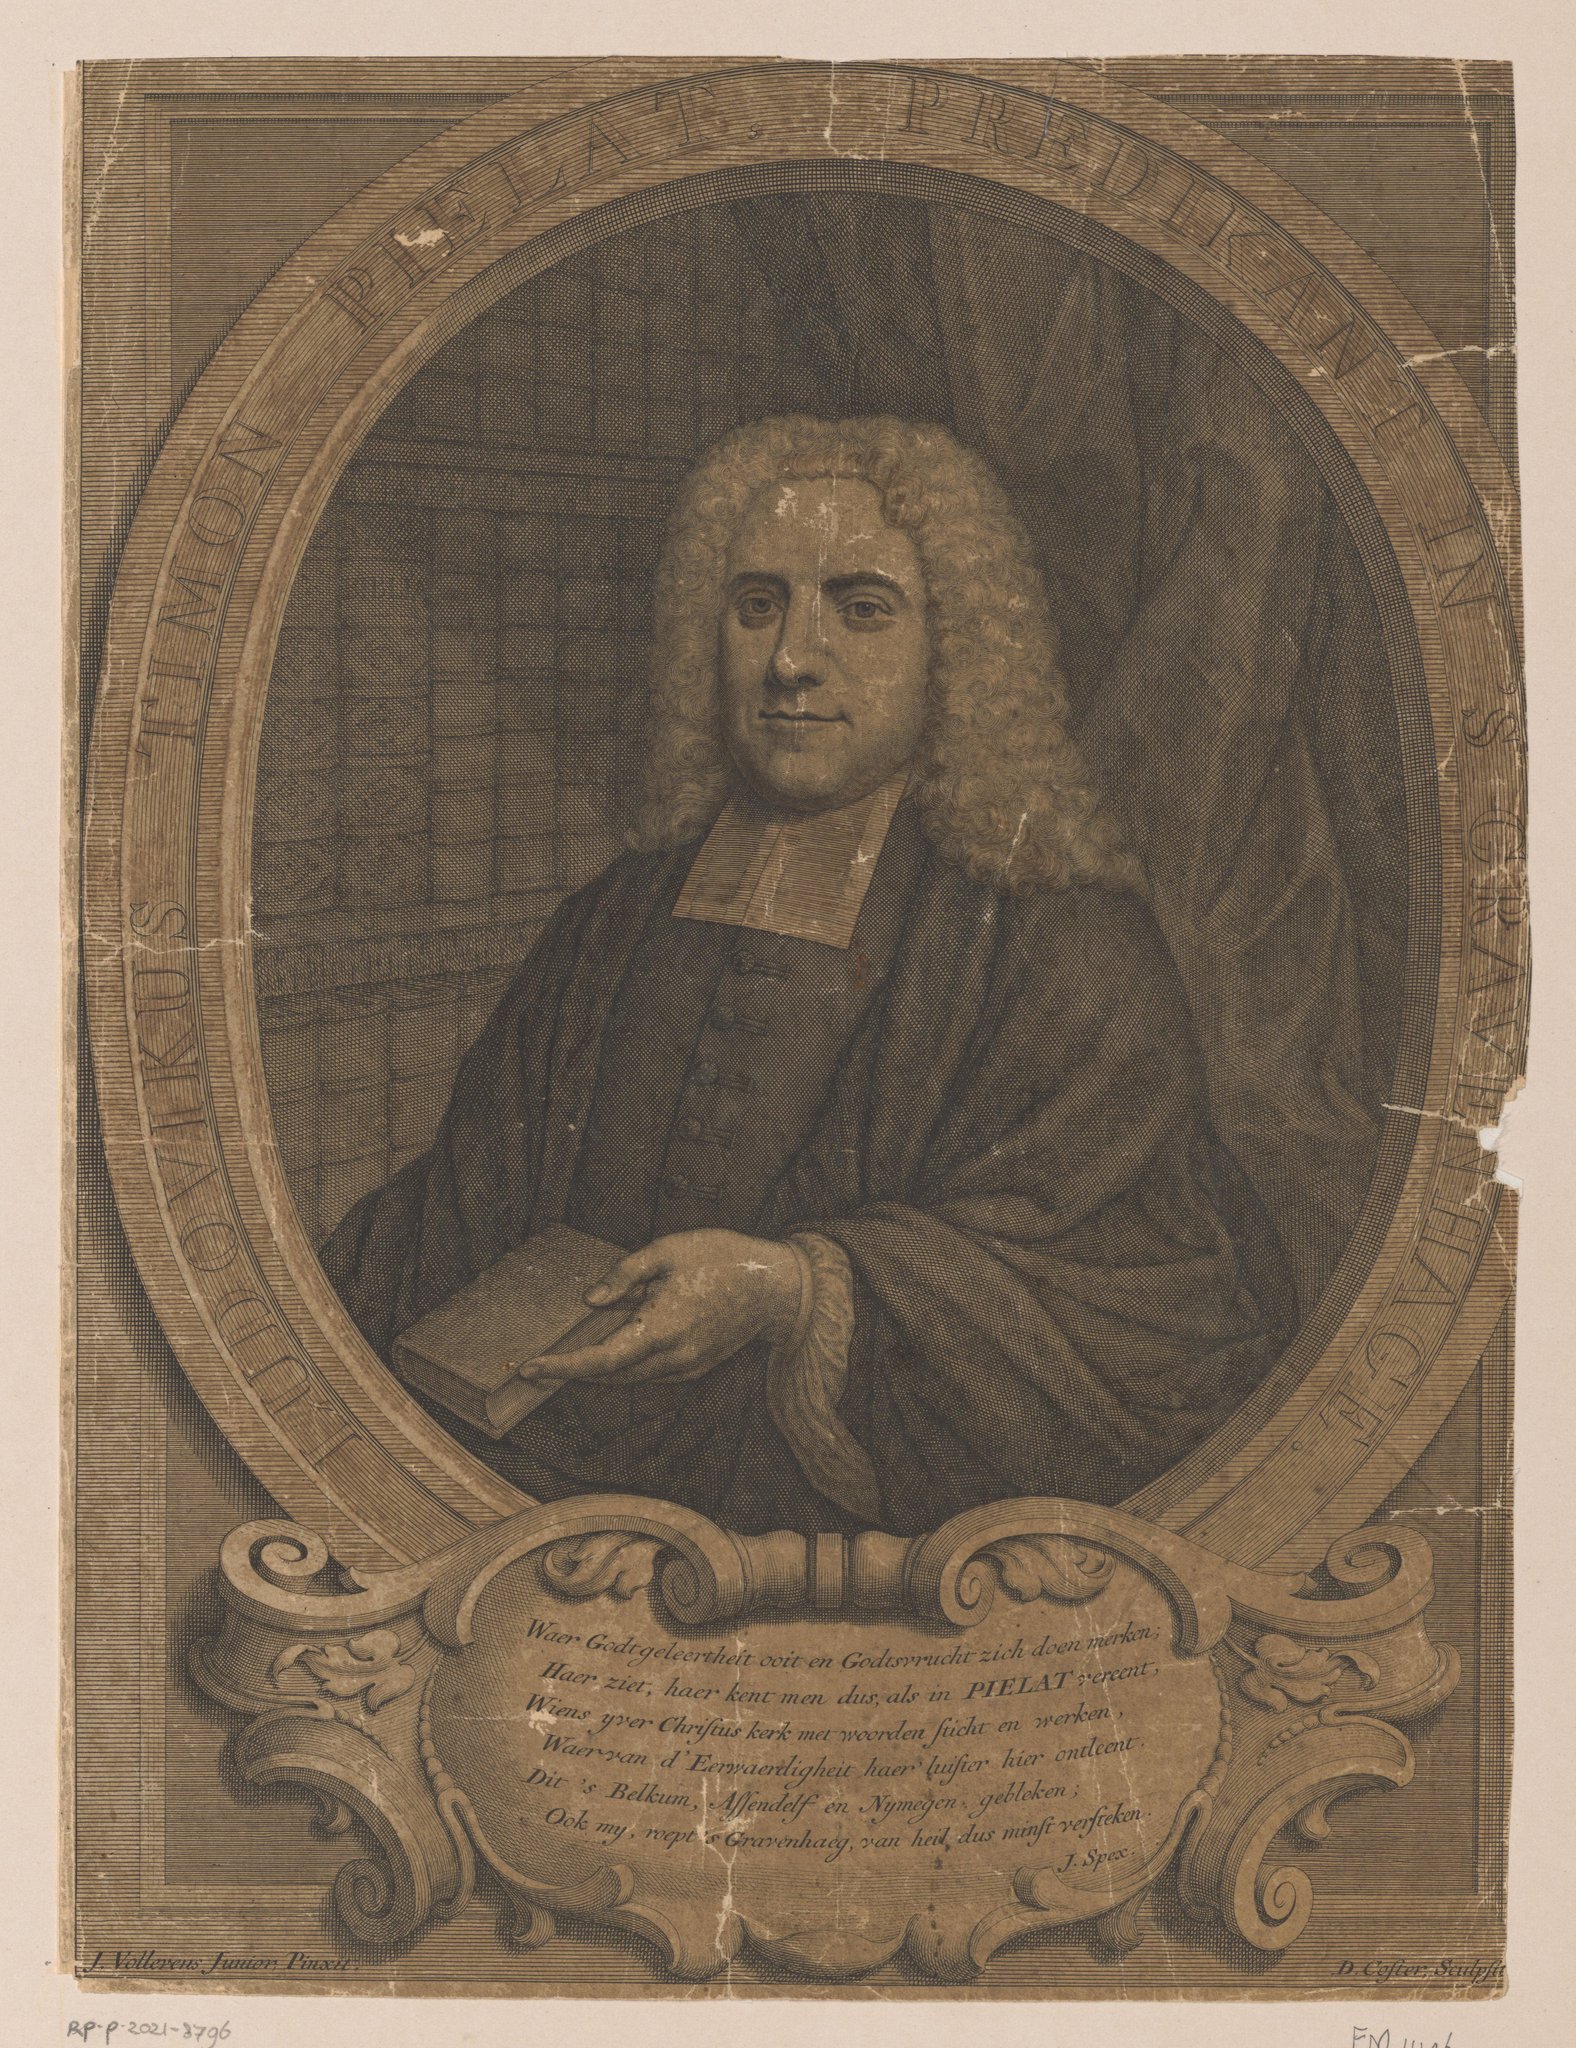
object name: print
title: Portret van Ludovicus Timon Pielat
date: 1715-1752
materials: paper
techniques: engraving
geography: the hague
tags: rotterdam, adult man, historical persons, book